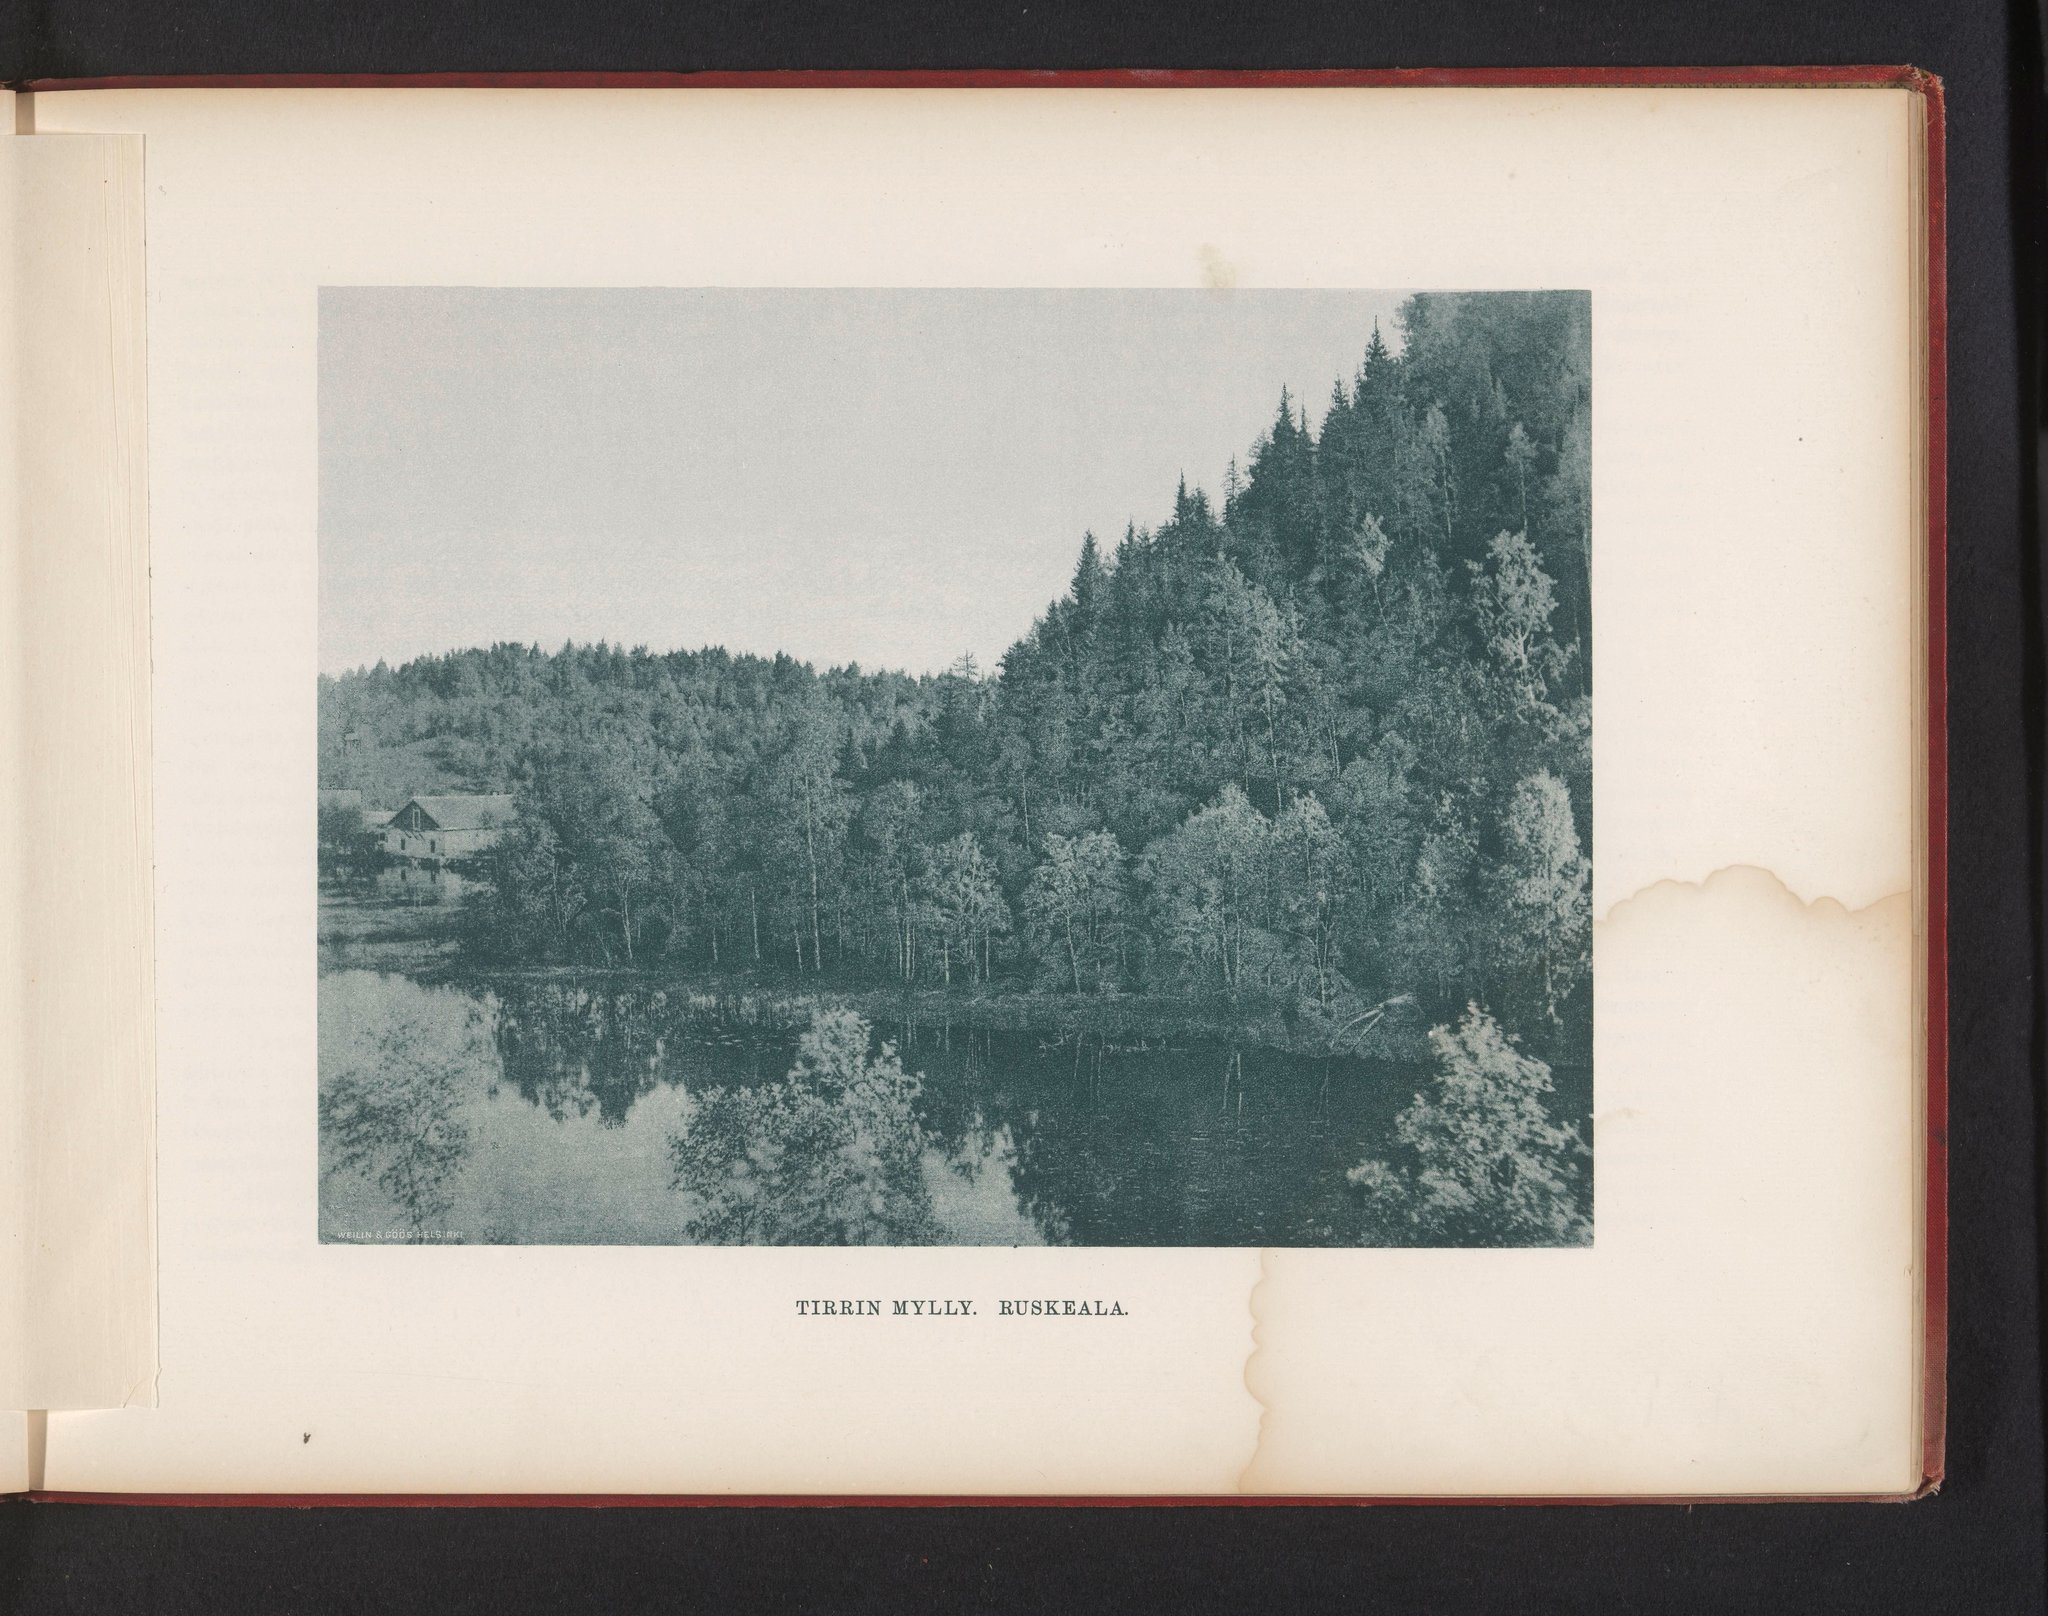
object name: photomechanical print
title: Tirrin Mylly - Ruskeala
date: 1888-1893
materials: paper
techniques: autotype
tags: trees, river, civic architecture; edifices; dwellings